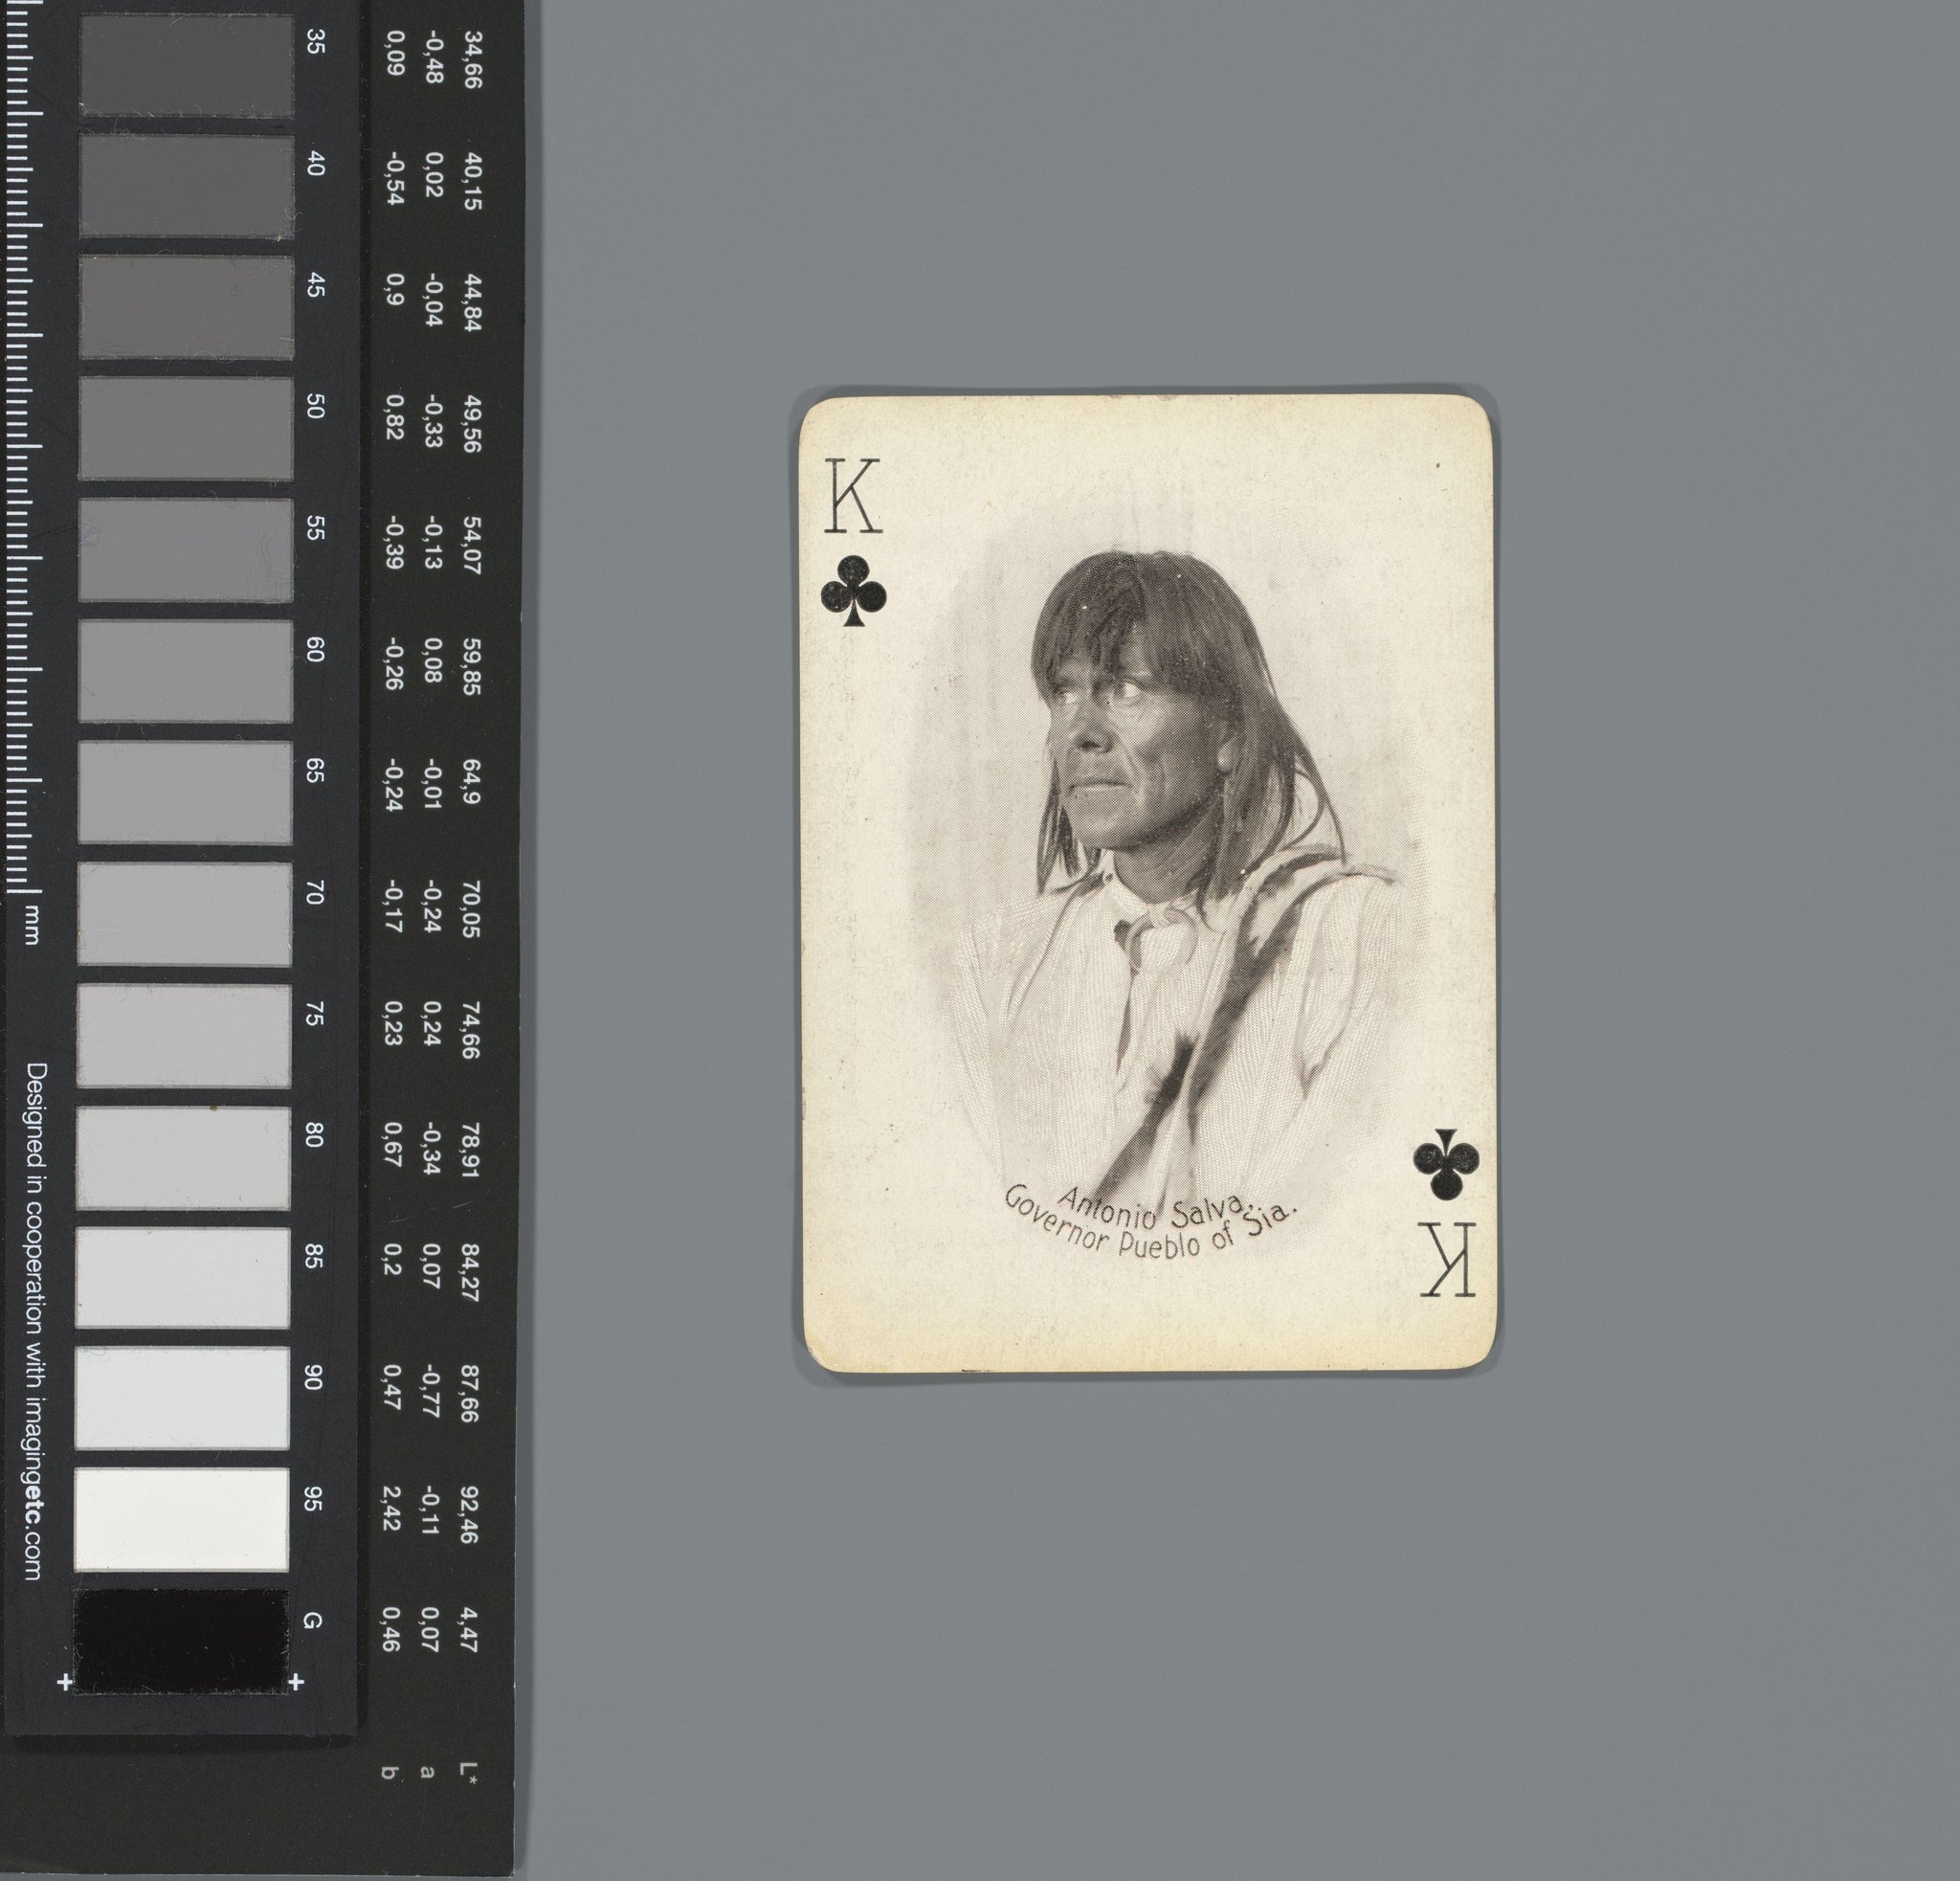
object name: photograph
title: Klaver koning met portret van Antonio Salva, gouverneur van Zia Pueblo, New Mexico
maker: adam clark vroman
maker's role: fotograaf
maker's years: 1856-1916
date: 1900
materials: paper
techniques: autotype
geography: los angeles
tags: new mexico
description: Speelkaart uit doosje met 53 speelkaarten met afbeeldingen in autotypie van Native Americans. De inhoud bevat een complete set speelkaarten inclusief joker.